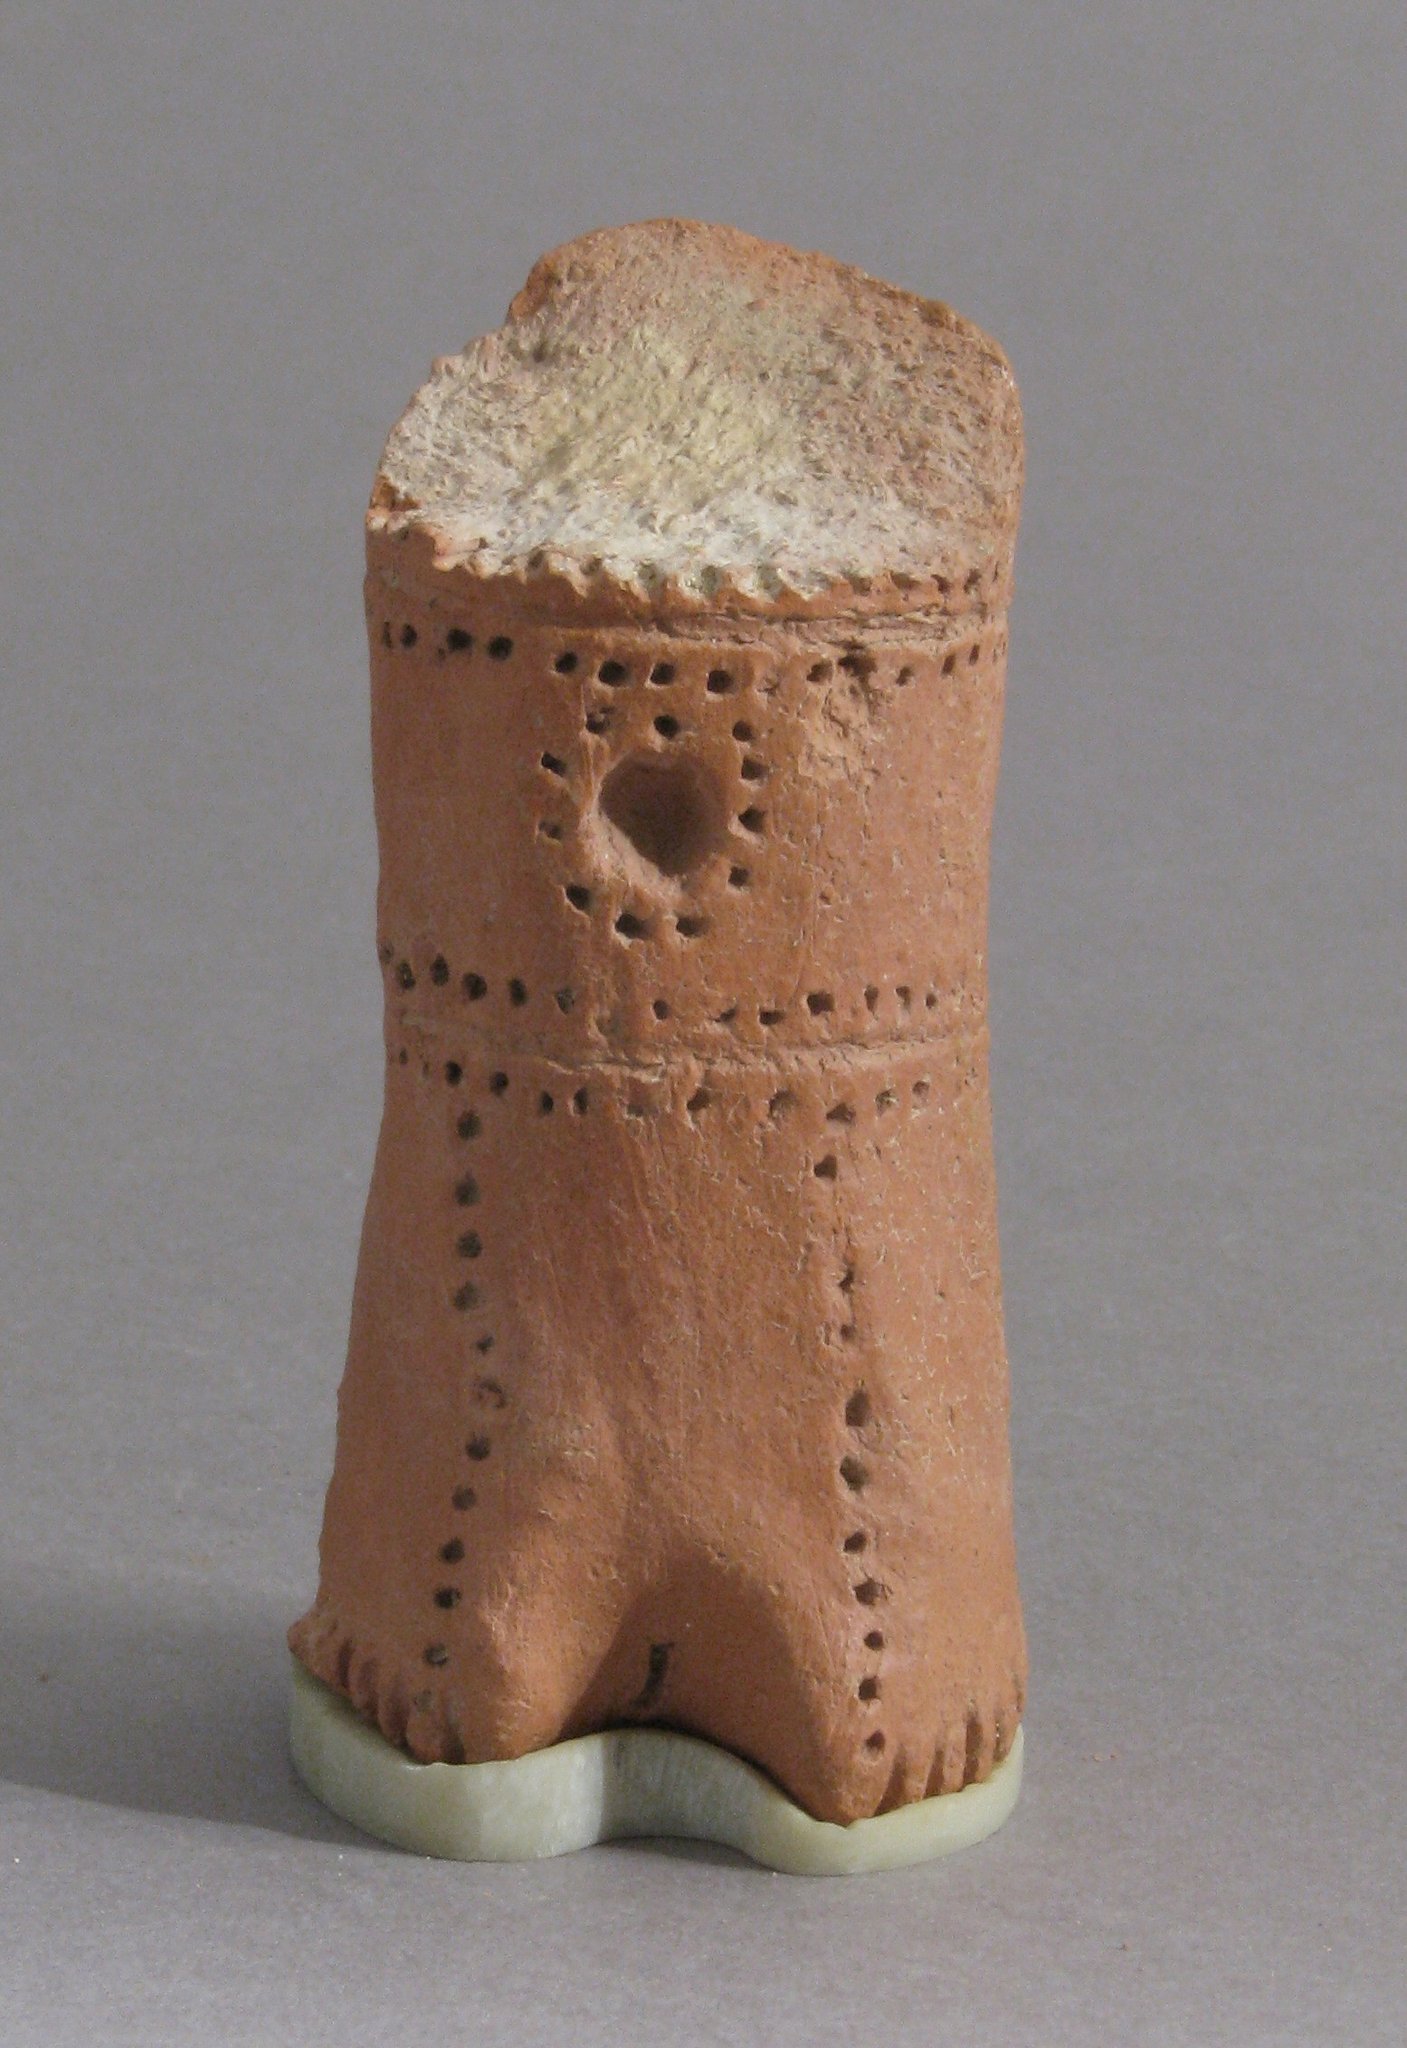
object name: fragment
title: Fragment of a Figure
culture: coptic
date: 301-700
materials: ceramic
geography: egypt